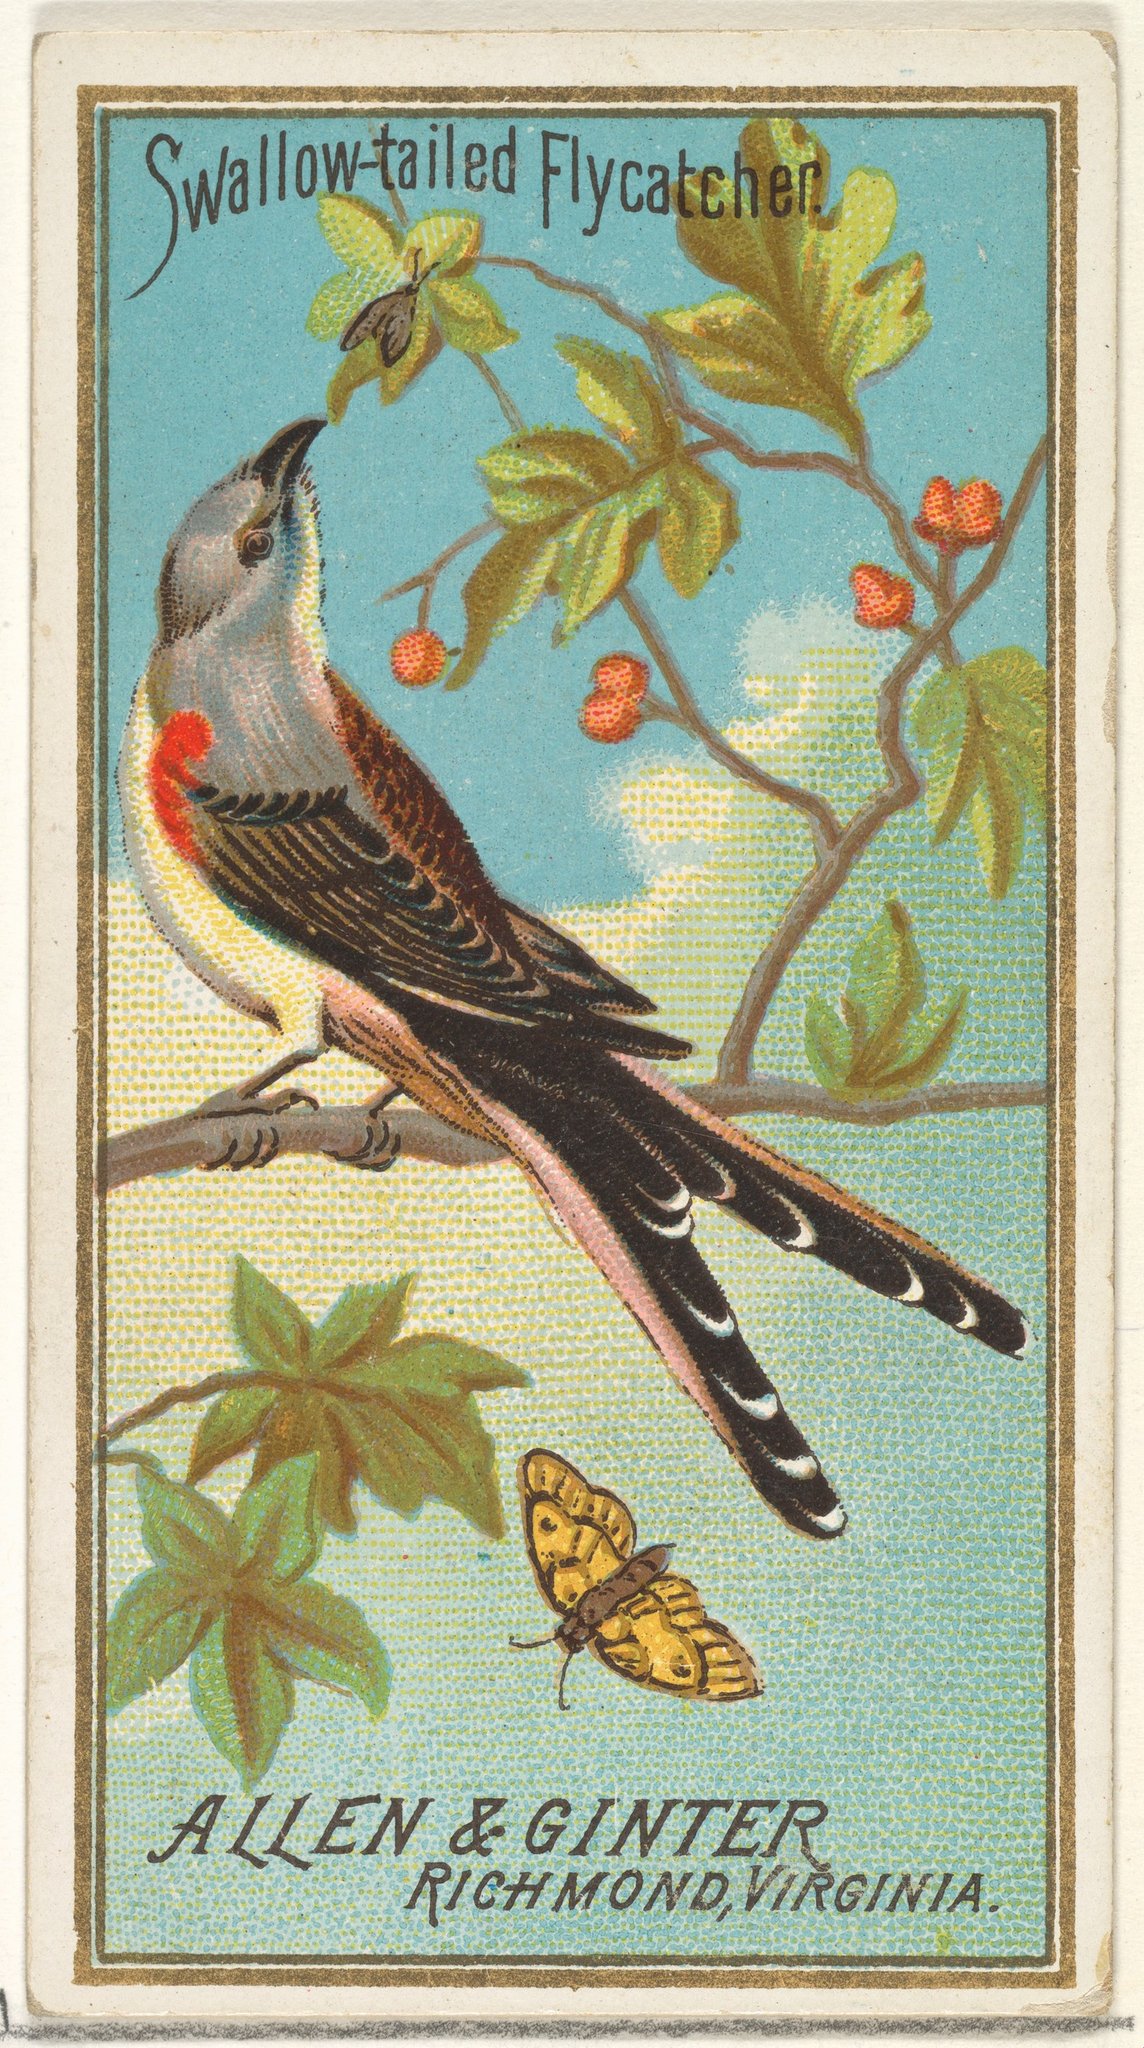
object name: print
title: Swallow-tailed Flycatcher, from the Birds of America series (N4) for Allen & Ginter Cigarettes Brands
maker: allen & ginter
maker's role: publisher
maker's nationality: american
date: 1888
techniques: color lithograph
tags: birds